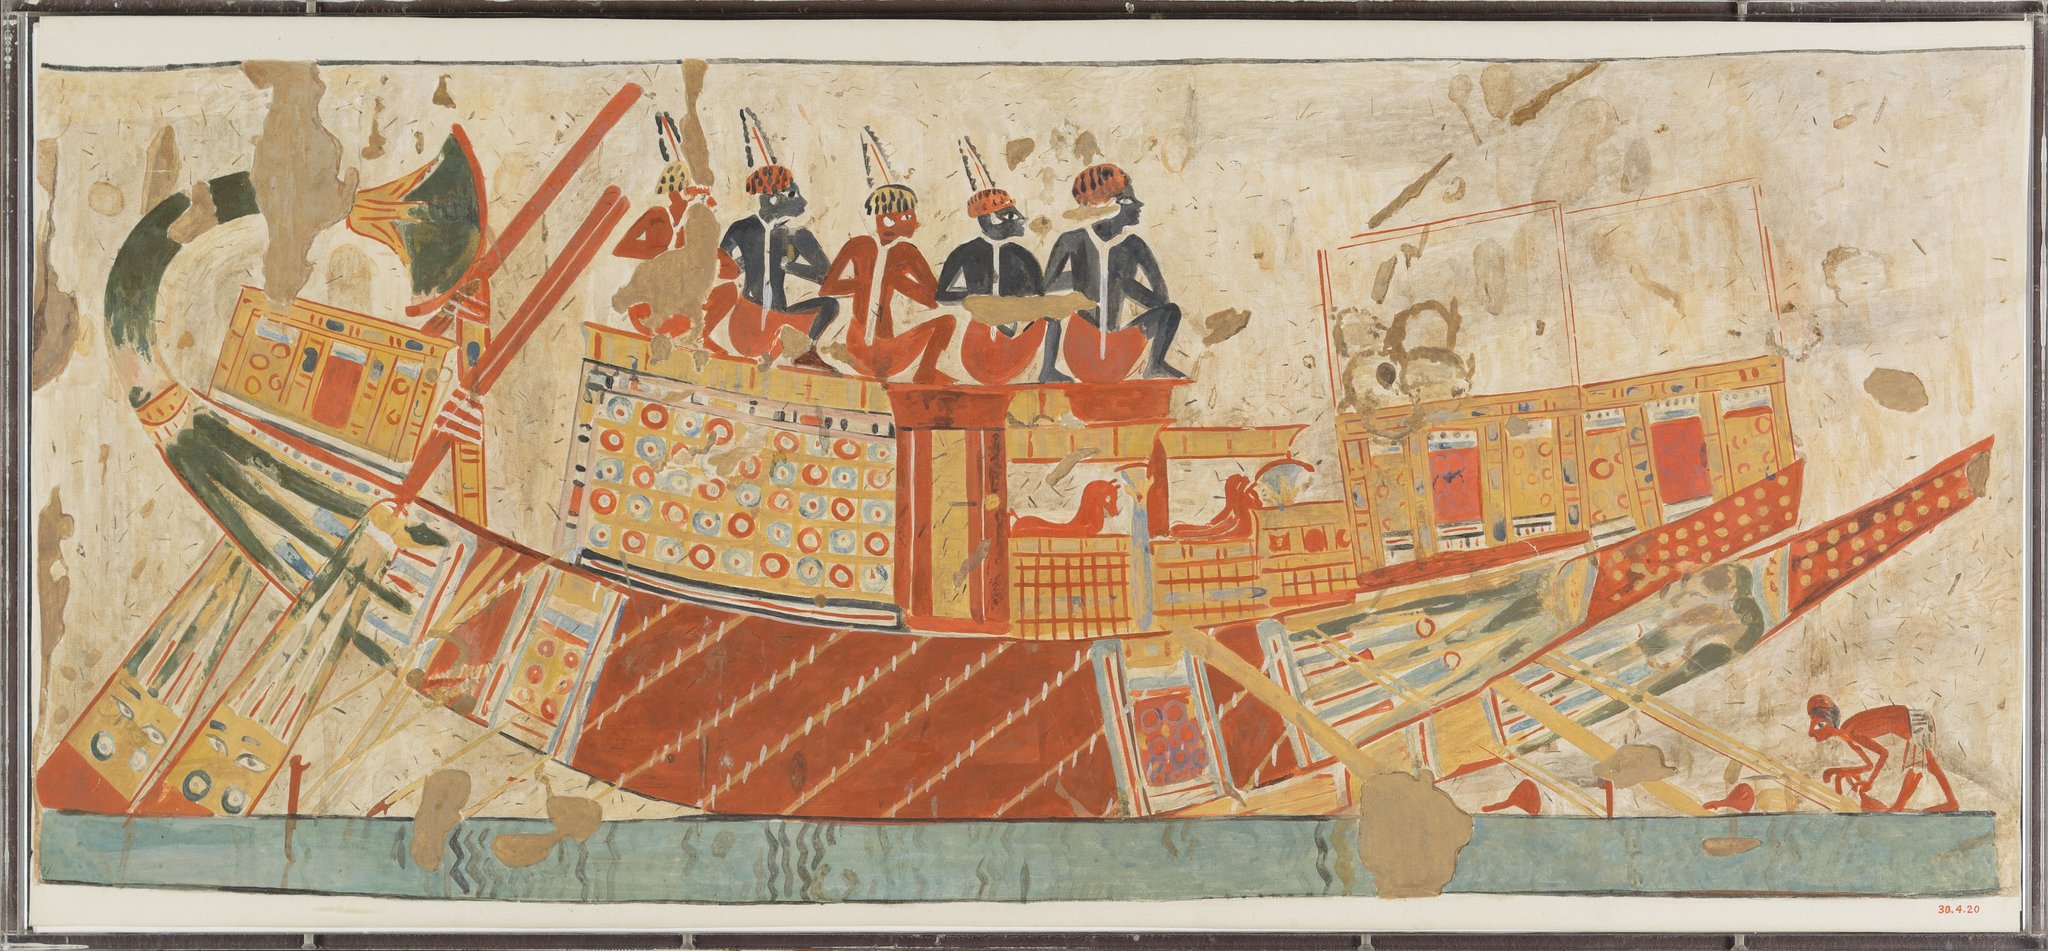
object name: facsimile, amenhotep huy tt 40, boat, nubian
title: Boat Carrying Captives from Nubia, Tomb of Huy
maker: charles k. wilkinson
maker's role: artist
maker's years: 1897-1986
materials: paper, paint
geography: egypt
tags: men,boats,walk-like-egyptian